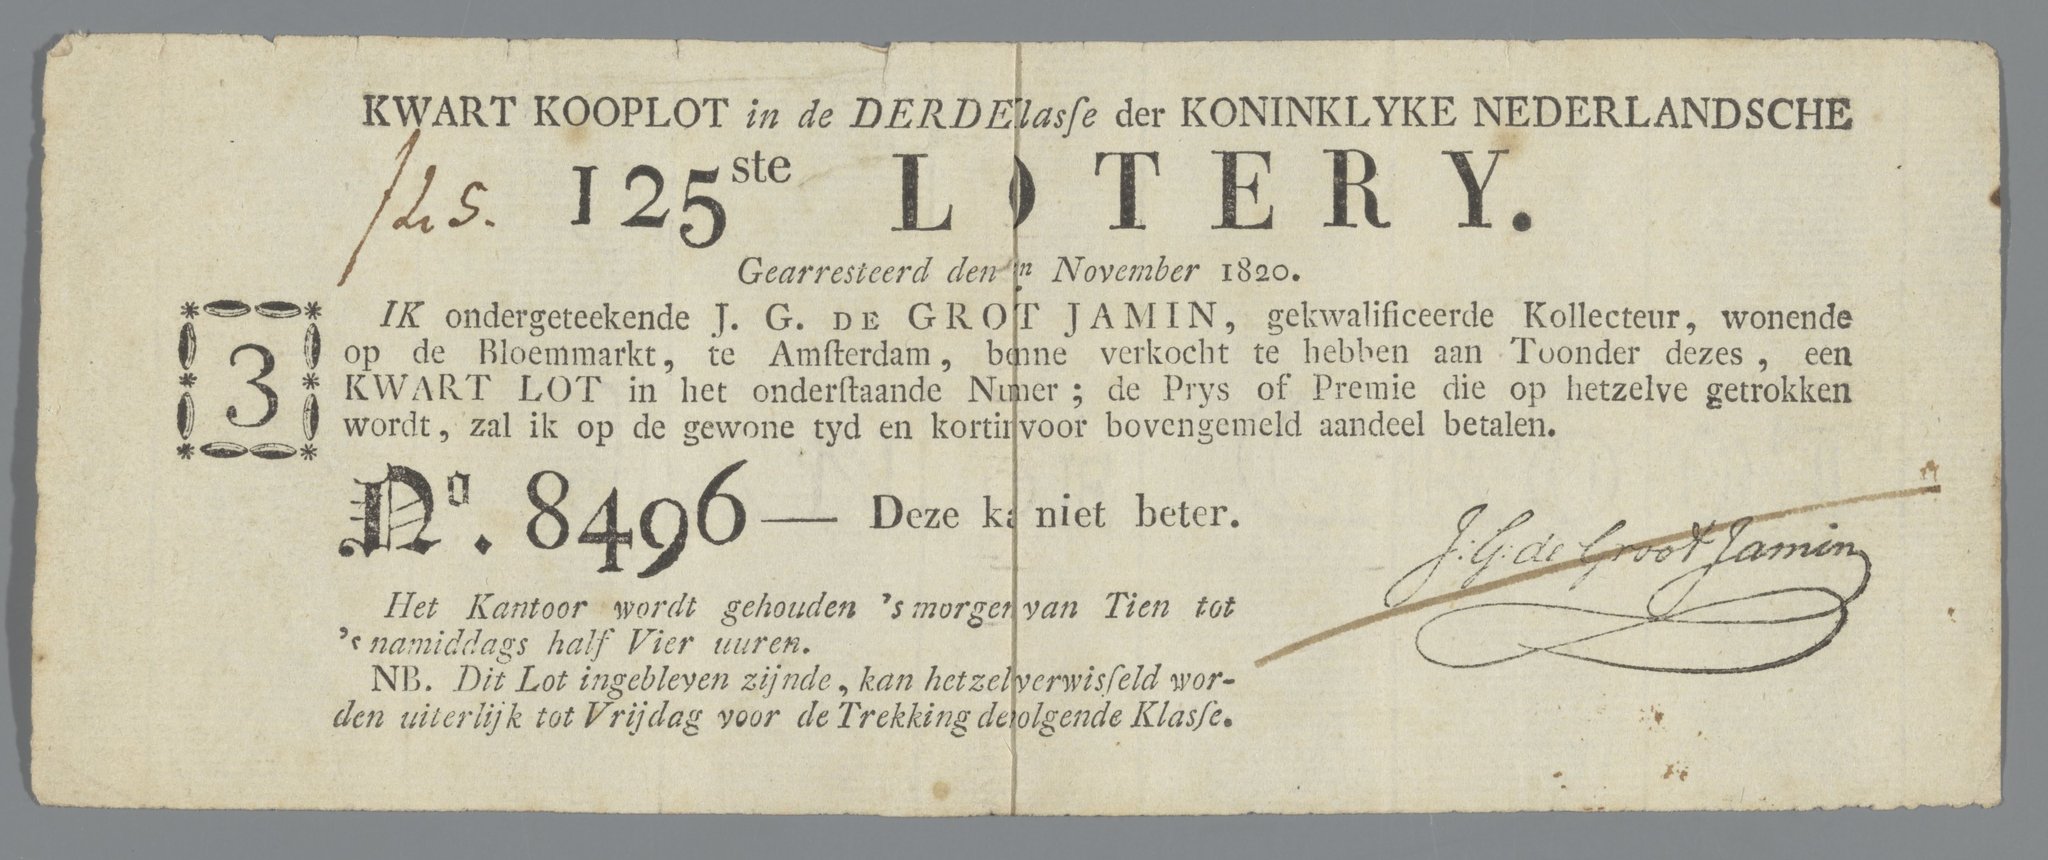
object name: loterijbrief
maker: j.g. de groot jamin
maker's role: schrijver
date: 1820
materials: paper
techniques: printing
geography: amsterdam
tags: netherlands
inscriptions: date